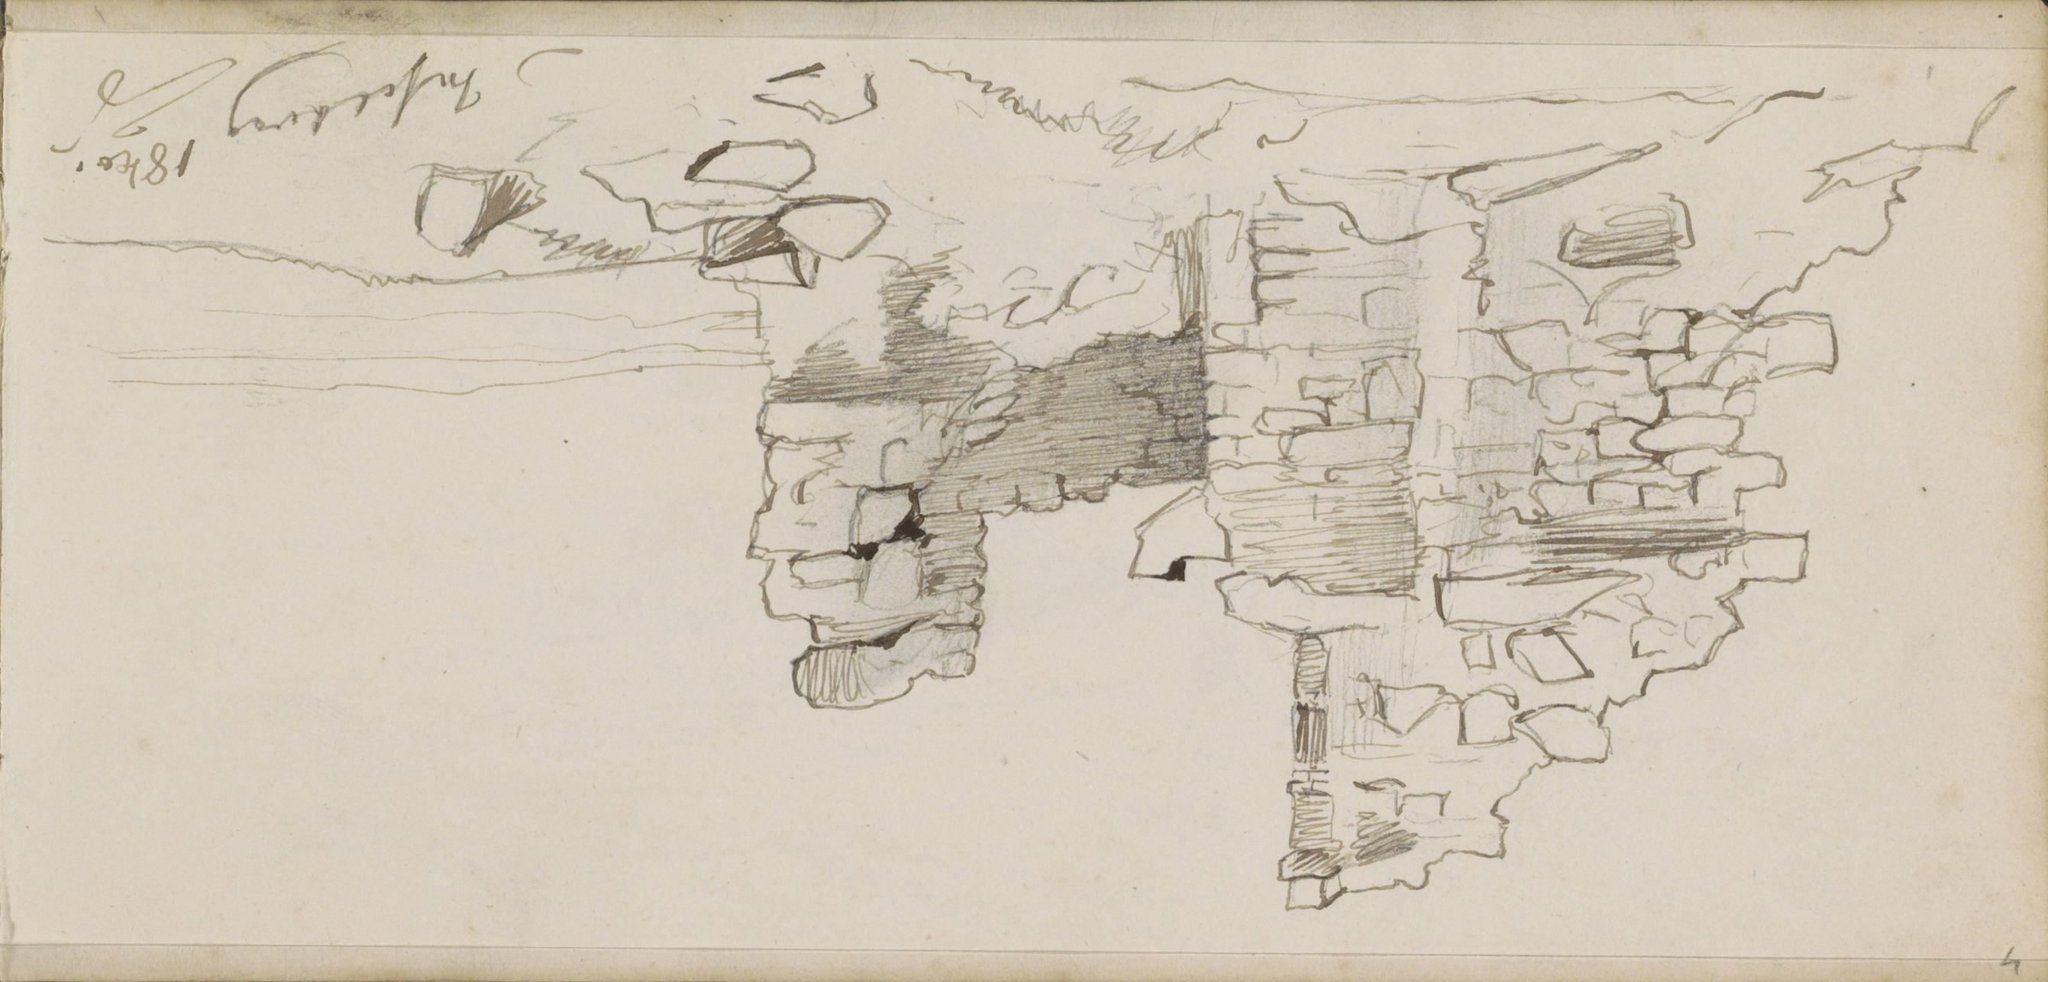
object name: sketchbook leaf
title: Ruïne op een eiland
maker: johannes tavenraat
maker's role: draughtsman, painter, print maker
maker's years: 1809-1881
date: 1840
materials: ink, paper, pencil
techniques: pen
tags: ruin of a dwelling, house, castle, etc.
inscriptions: date and inscription: ‘Inselburg 1840.’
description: Vermoedelijk een ruïne van een kasteel. Blad 4 recto uit een schetsboek met 63 bladen.